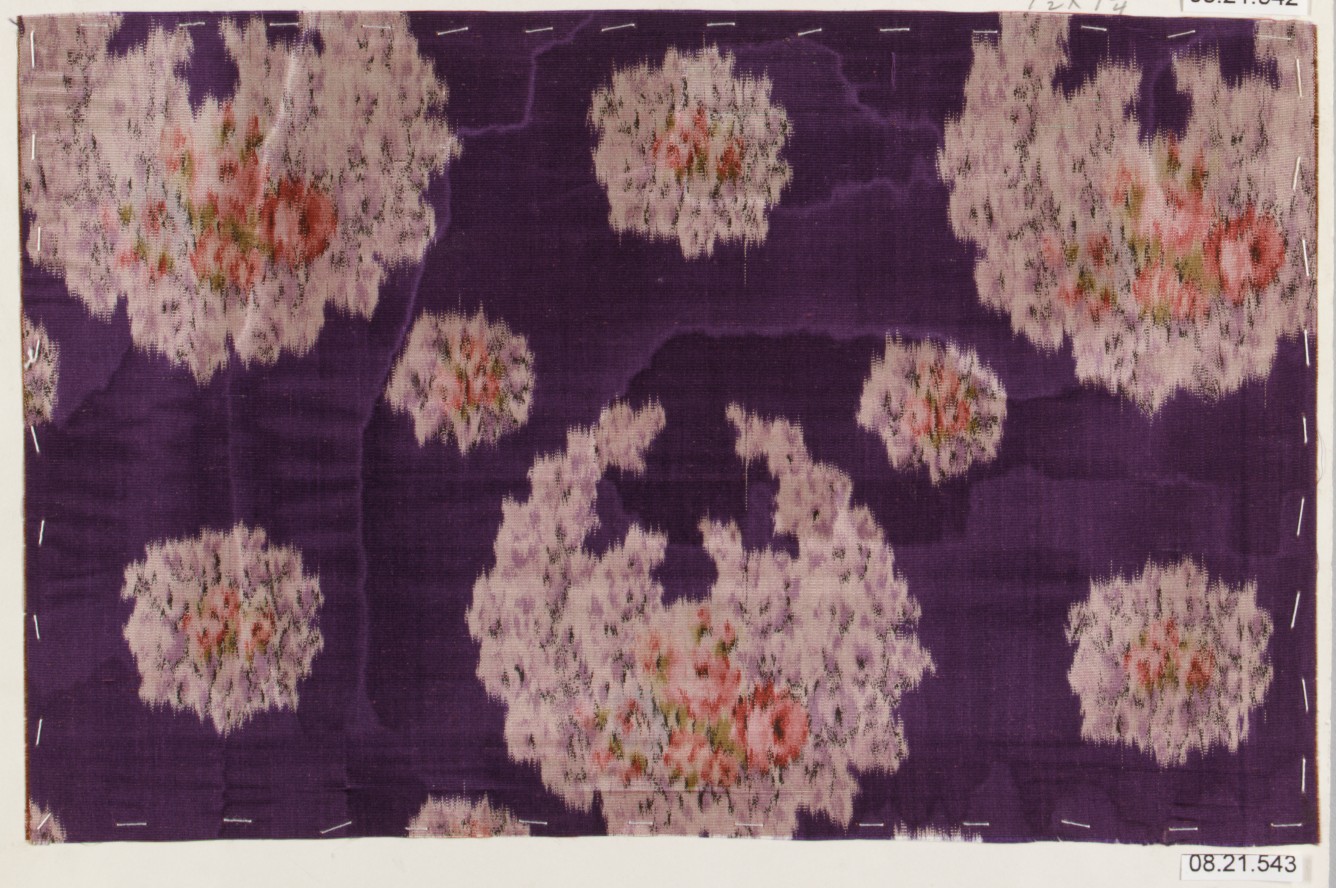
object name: textile sample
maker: Anonymous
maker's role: designer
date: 1900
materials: silk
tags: flowers